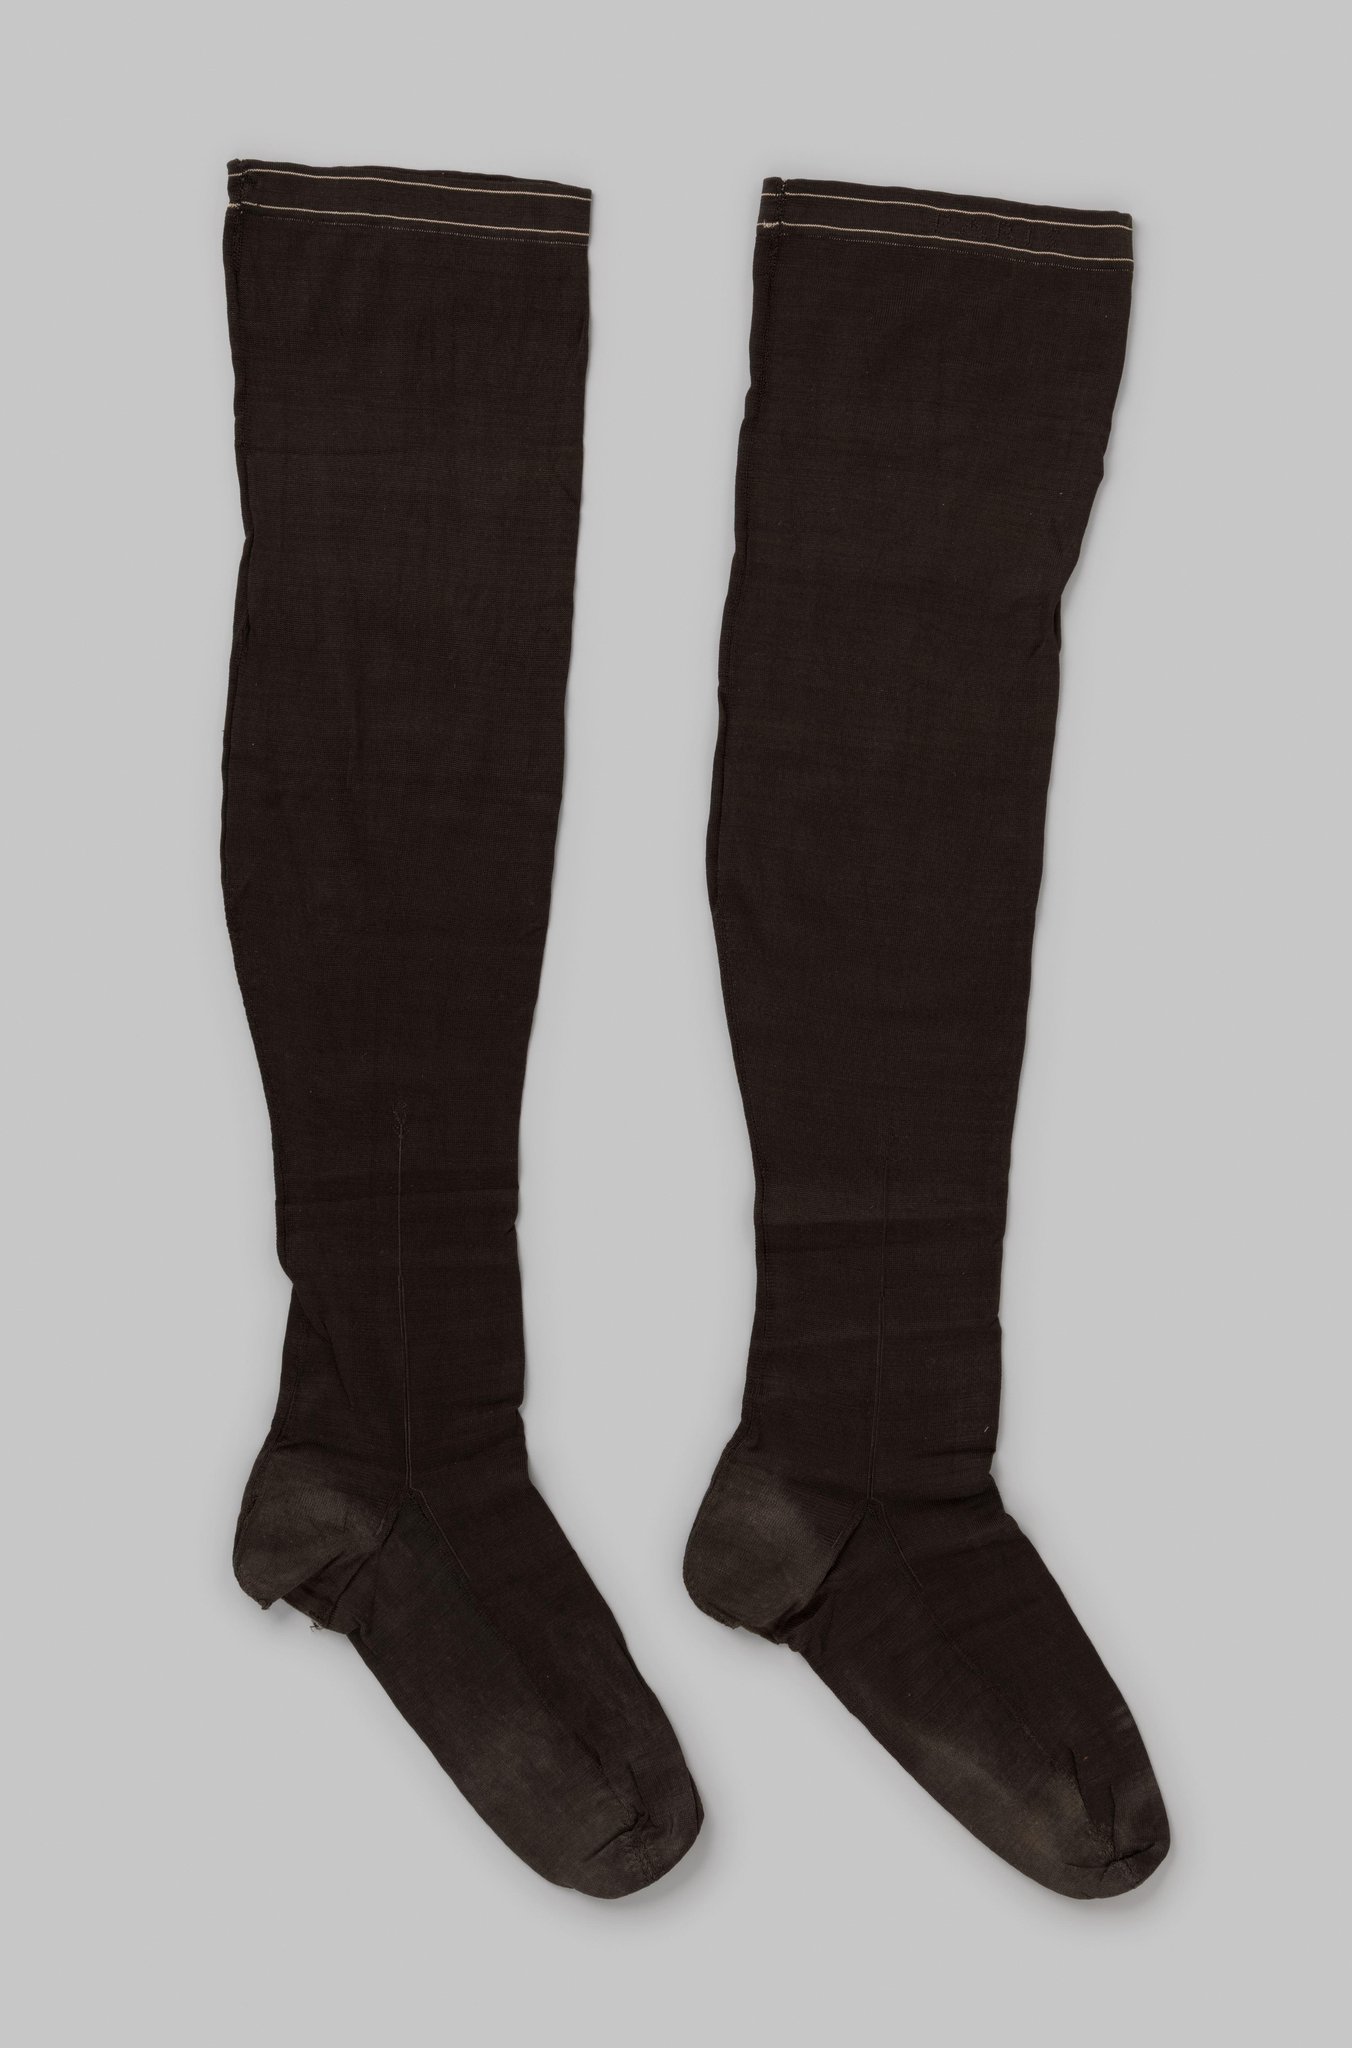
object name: clothing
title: Kous van effen glanzende donkerbruin of zwarte katoenen tricot met bij de klink een geborduurde verticale lijn, uitlopend in een bloem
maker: Anonymous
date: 1700-1800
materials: cotton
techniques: embroidered, knitting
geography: paris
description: Kous van glanzende zwarte katoenen tricot, met naad. Aan beide zijden hiel geborduurde verticale lijn uitlopend in een bloem. Aan bovenzijde twee smalle ecrukleurige horizontale banden.